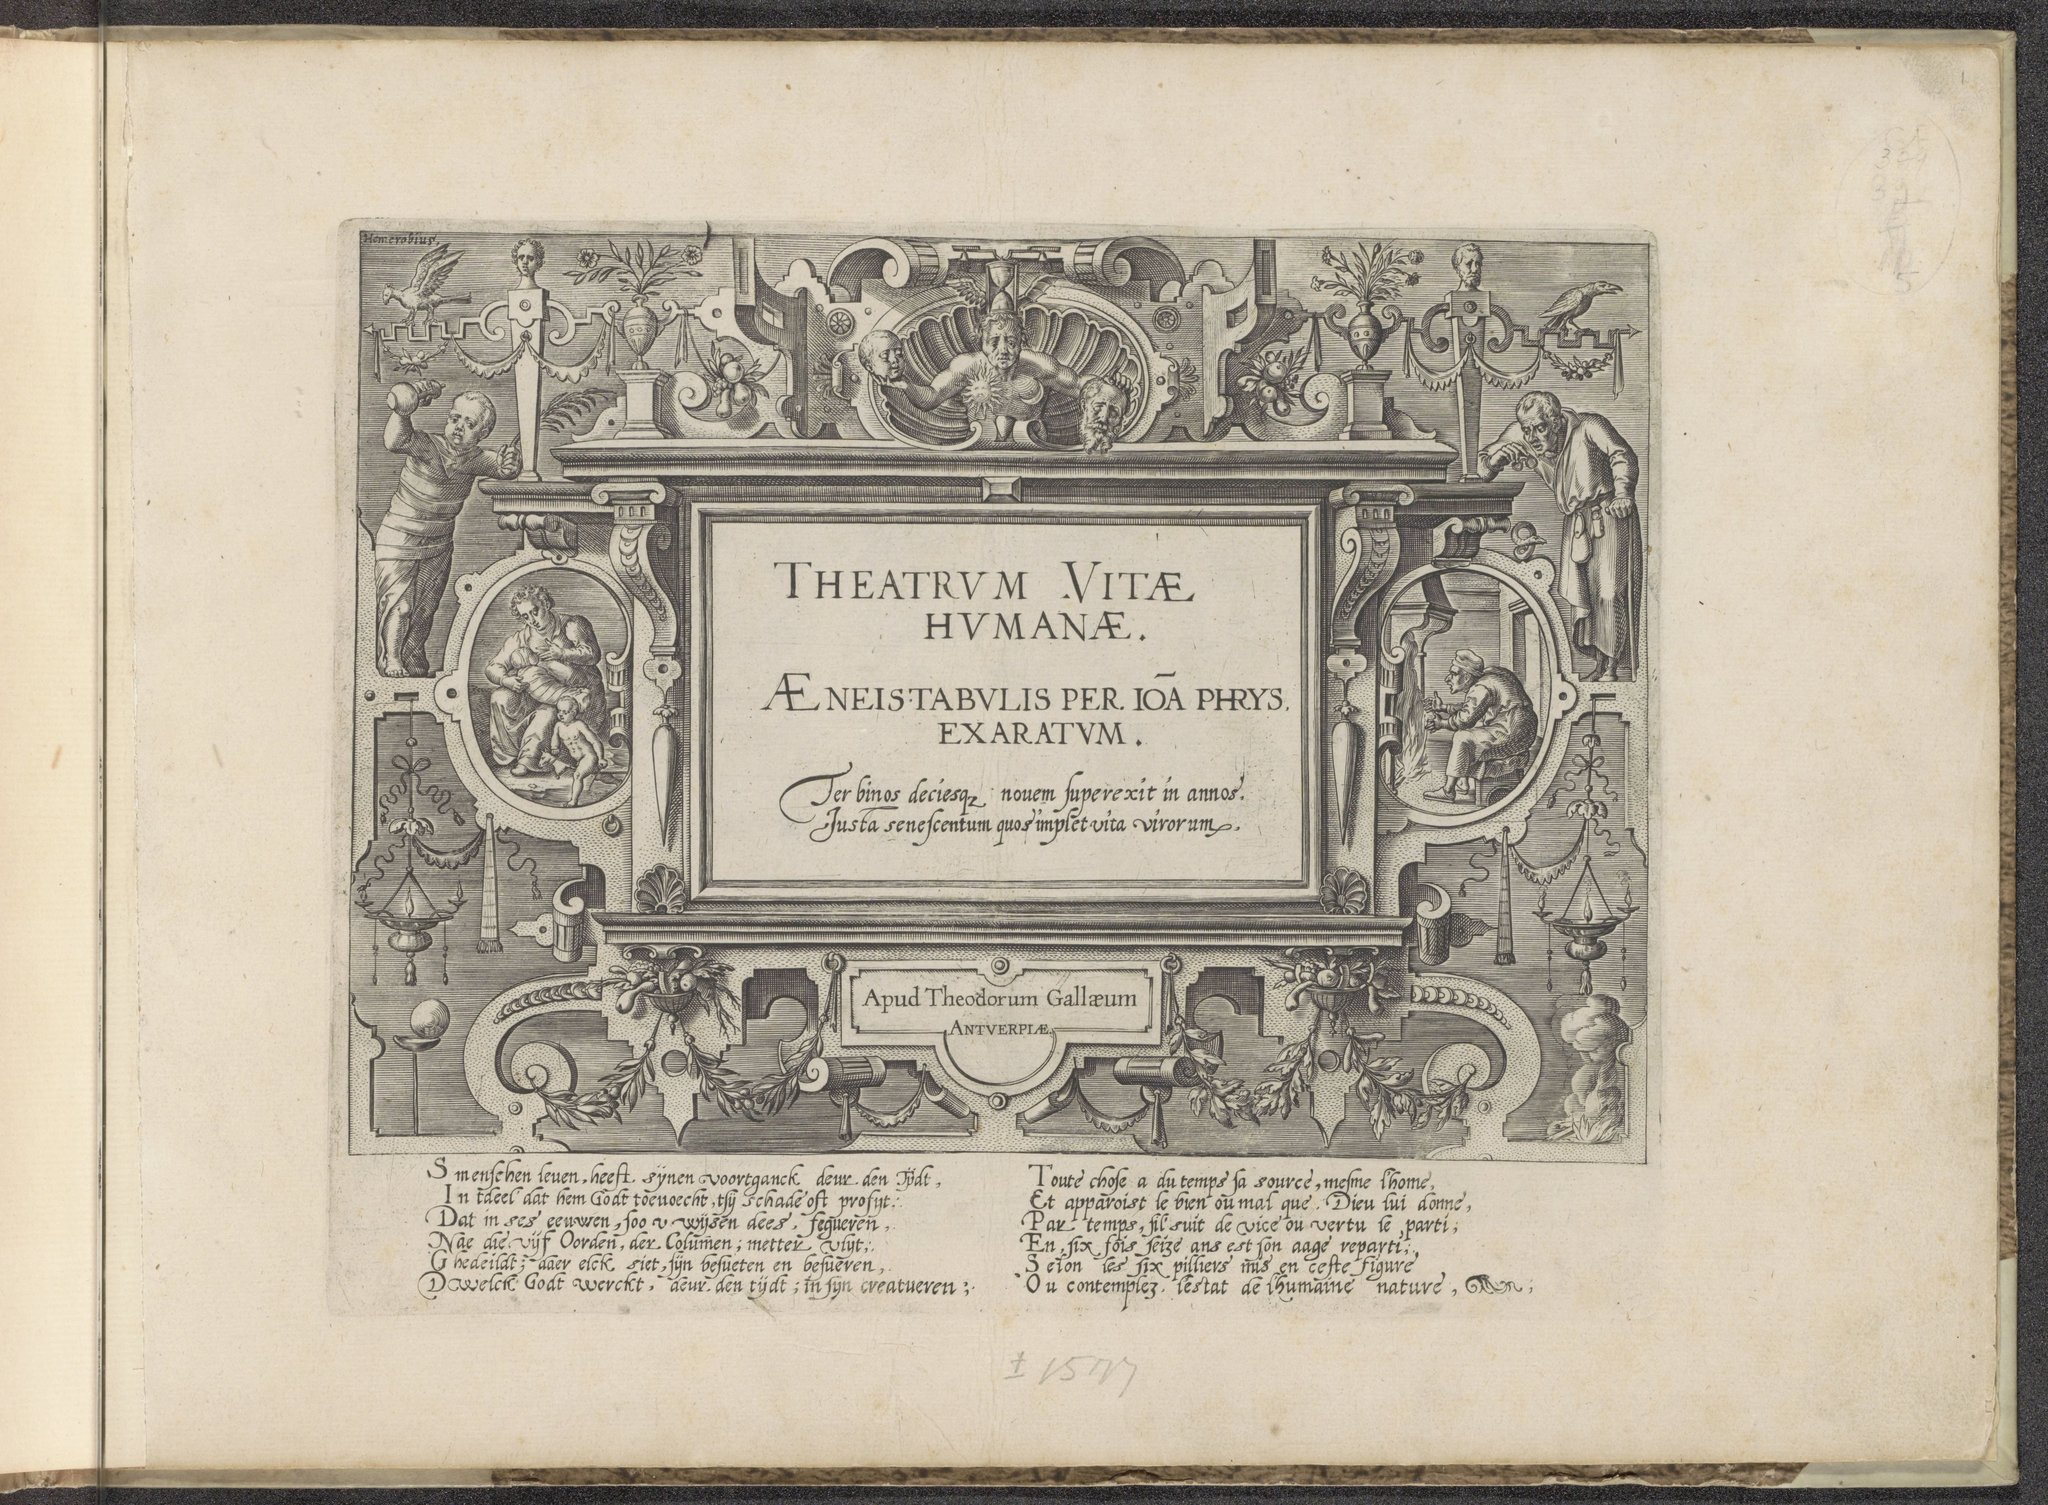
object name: album leaf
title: Zes leeftijden van de mens / zes bouwordes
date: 1598-1602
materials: paper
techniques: engraving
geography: antwerp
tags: eyeglasses, spectacles, nursing, suckling, the ages of man, hobby-horse, title-page, old man, ornament derived from architectural details, allegory of time and eternity, open fire, fire-place, stove (in kitchen)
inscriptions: collector's mark: Lugt 2166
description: Titelprent met op een epitaaf de titel van de serie: Theatrum Vitae Humanae. De ornamentele omlijsting is versierd met symbolen die verwijzingen naar de eerste en laatste levensfase van de mens. Links een baby en daarbij een cartouche met een moeder die haar kind zoogt. Voor haar speelt een kind op een stokpaard. Rechts een man met een bril en een stok. In de cartouche rechts verwarmt een oude man zich aan een haardvuur. Boven de titel de personificatie van de tijd met op zijn hoofd een gevleugelde zandloper en op zijn borst de zon en maan. In zijn handen het hoofd van een baby en het hoofd van een oude man. Verder onder meer guirlandes, fruitmanden en vogels. In de ondermarge zes versregels in het Nederlands en Frans. De prent maakt deel uit van een album.